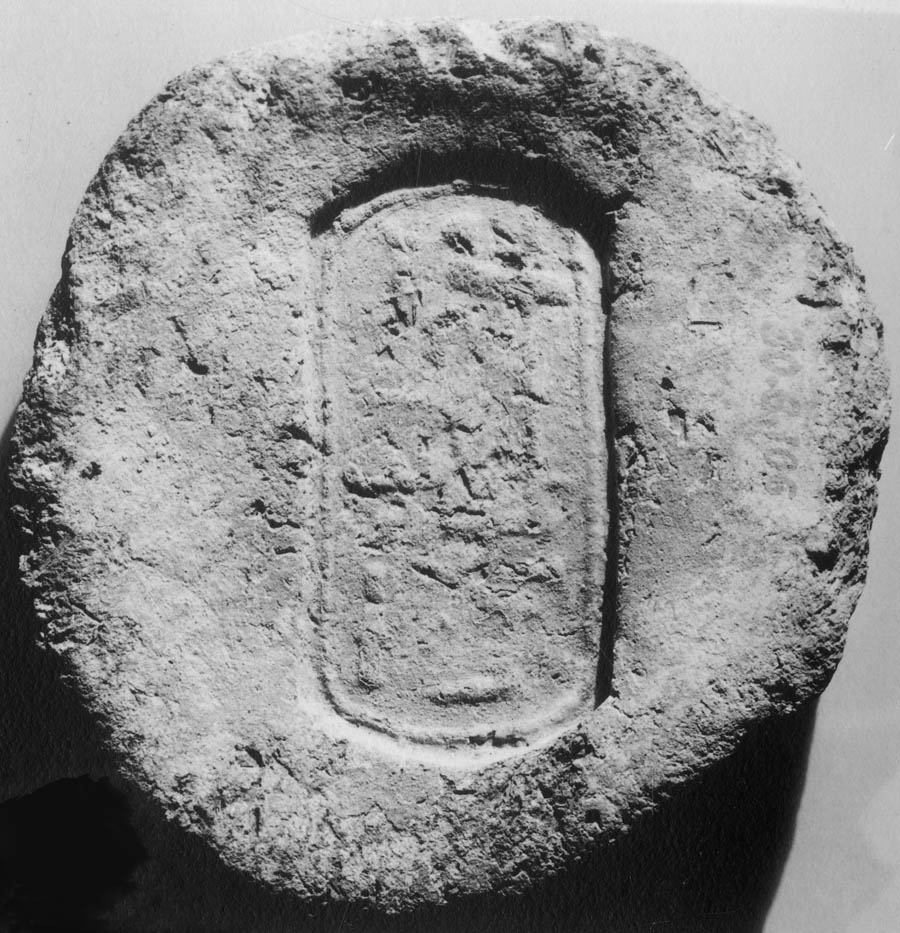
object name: cone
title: Funerary Cone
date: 1550-1295 BCE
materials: pottery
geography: egypt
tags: cartouches